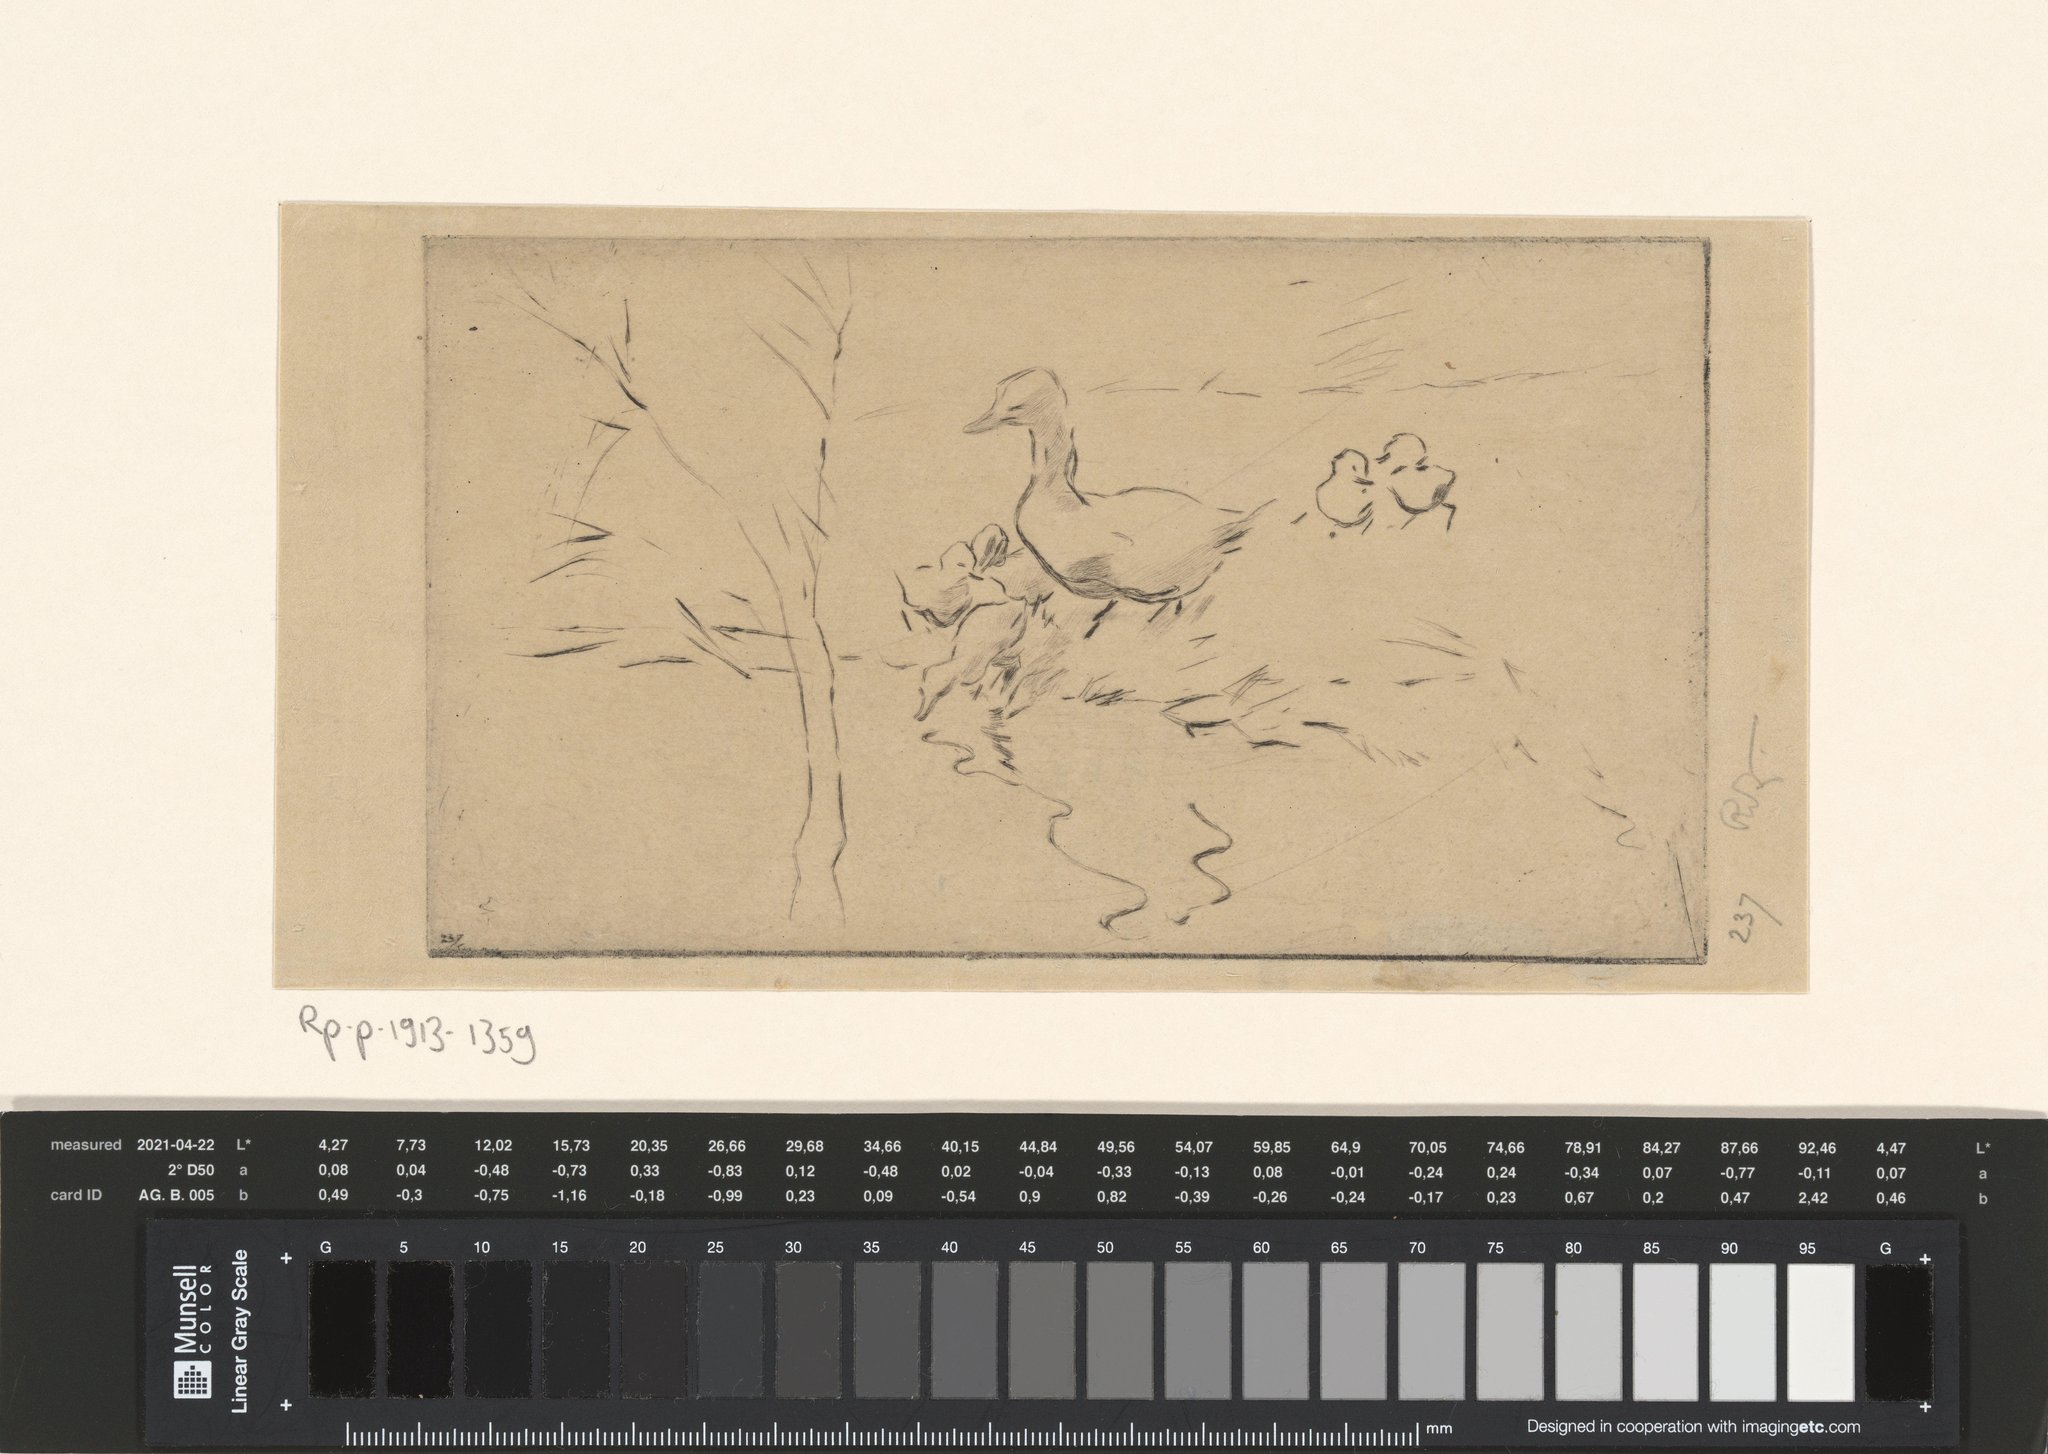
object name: print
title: Canards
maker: philip zilcken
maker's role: draughtsman, painter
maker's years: 1857-1930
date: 1890-1913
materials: paper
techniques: drypoint, intaglio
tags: water-birds: duck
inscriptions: collector's mark: Lugt 2233